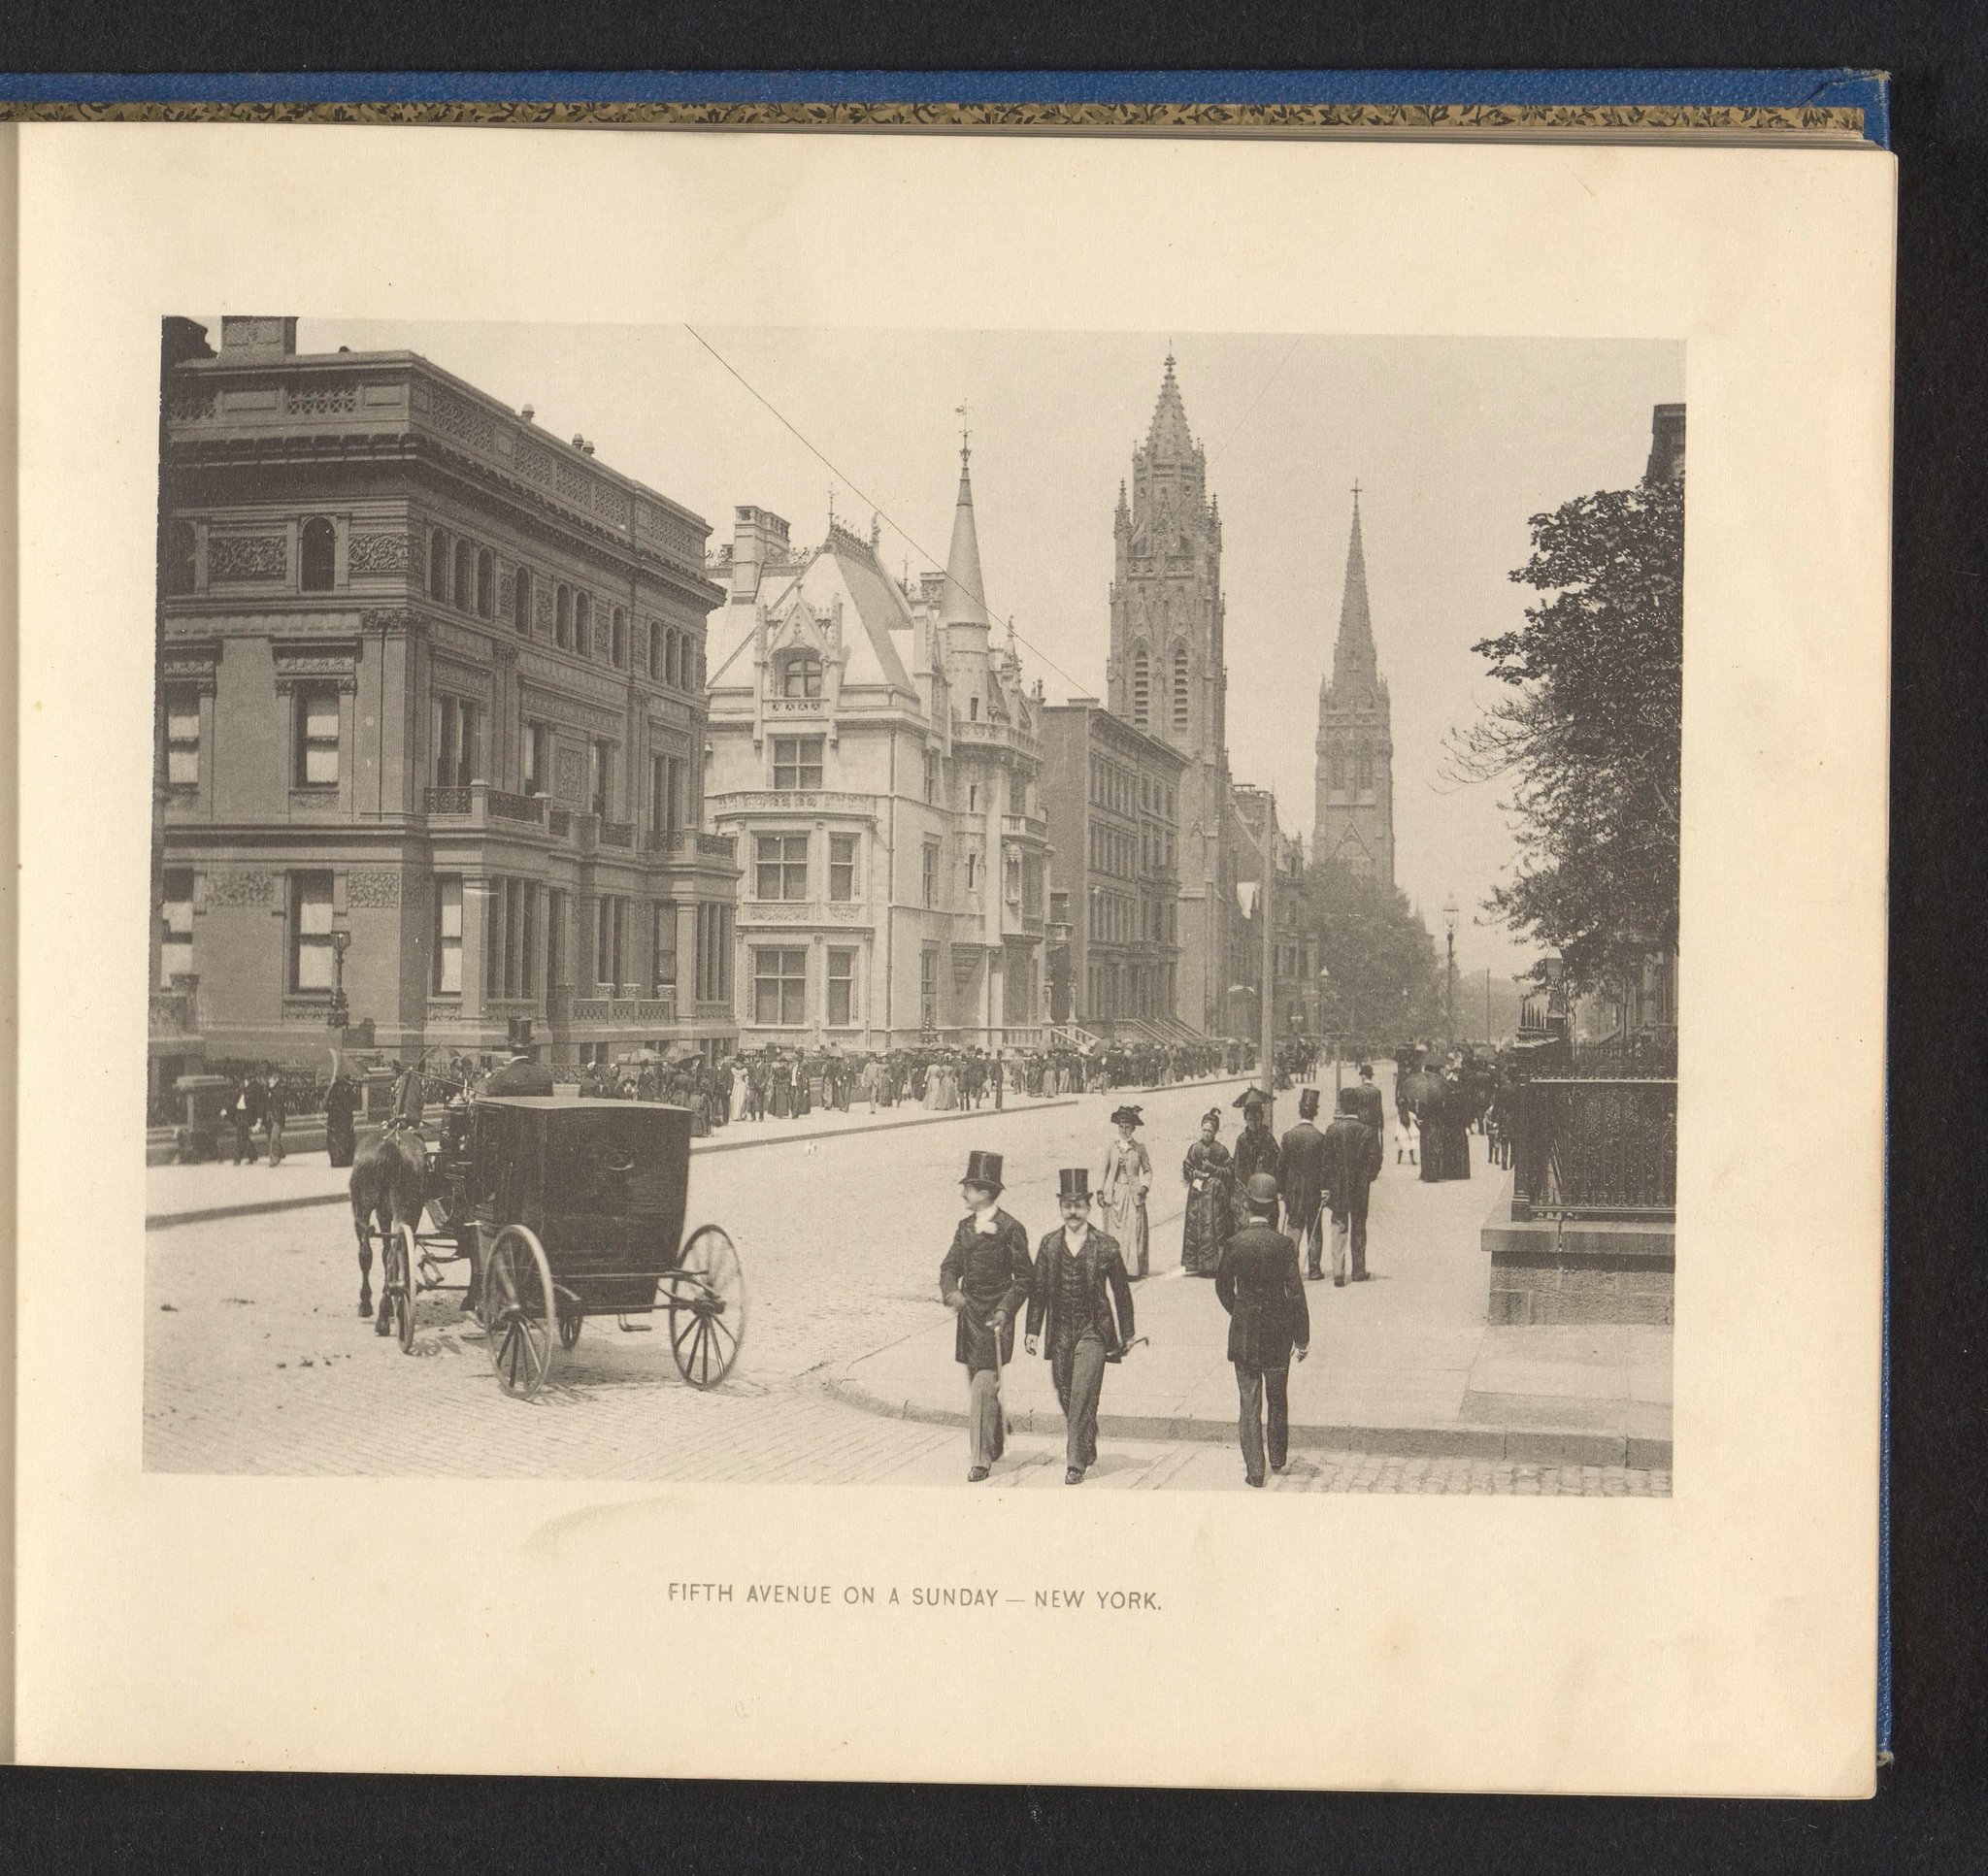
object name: photomechanical print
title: Fifth Avenue on a Sunday - New York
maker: Anonymous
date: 1883-1893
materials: paper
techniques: photograph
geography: new york city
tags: strolling, four-wheeled, animal-drawn vehicle, e.g.: cab, carriage, coach, street, new york (city)